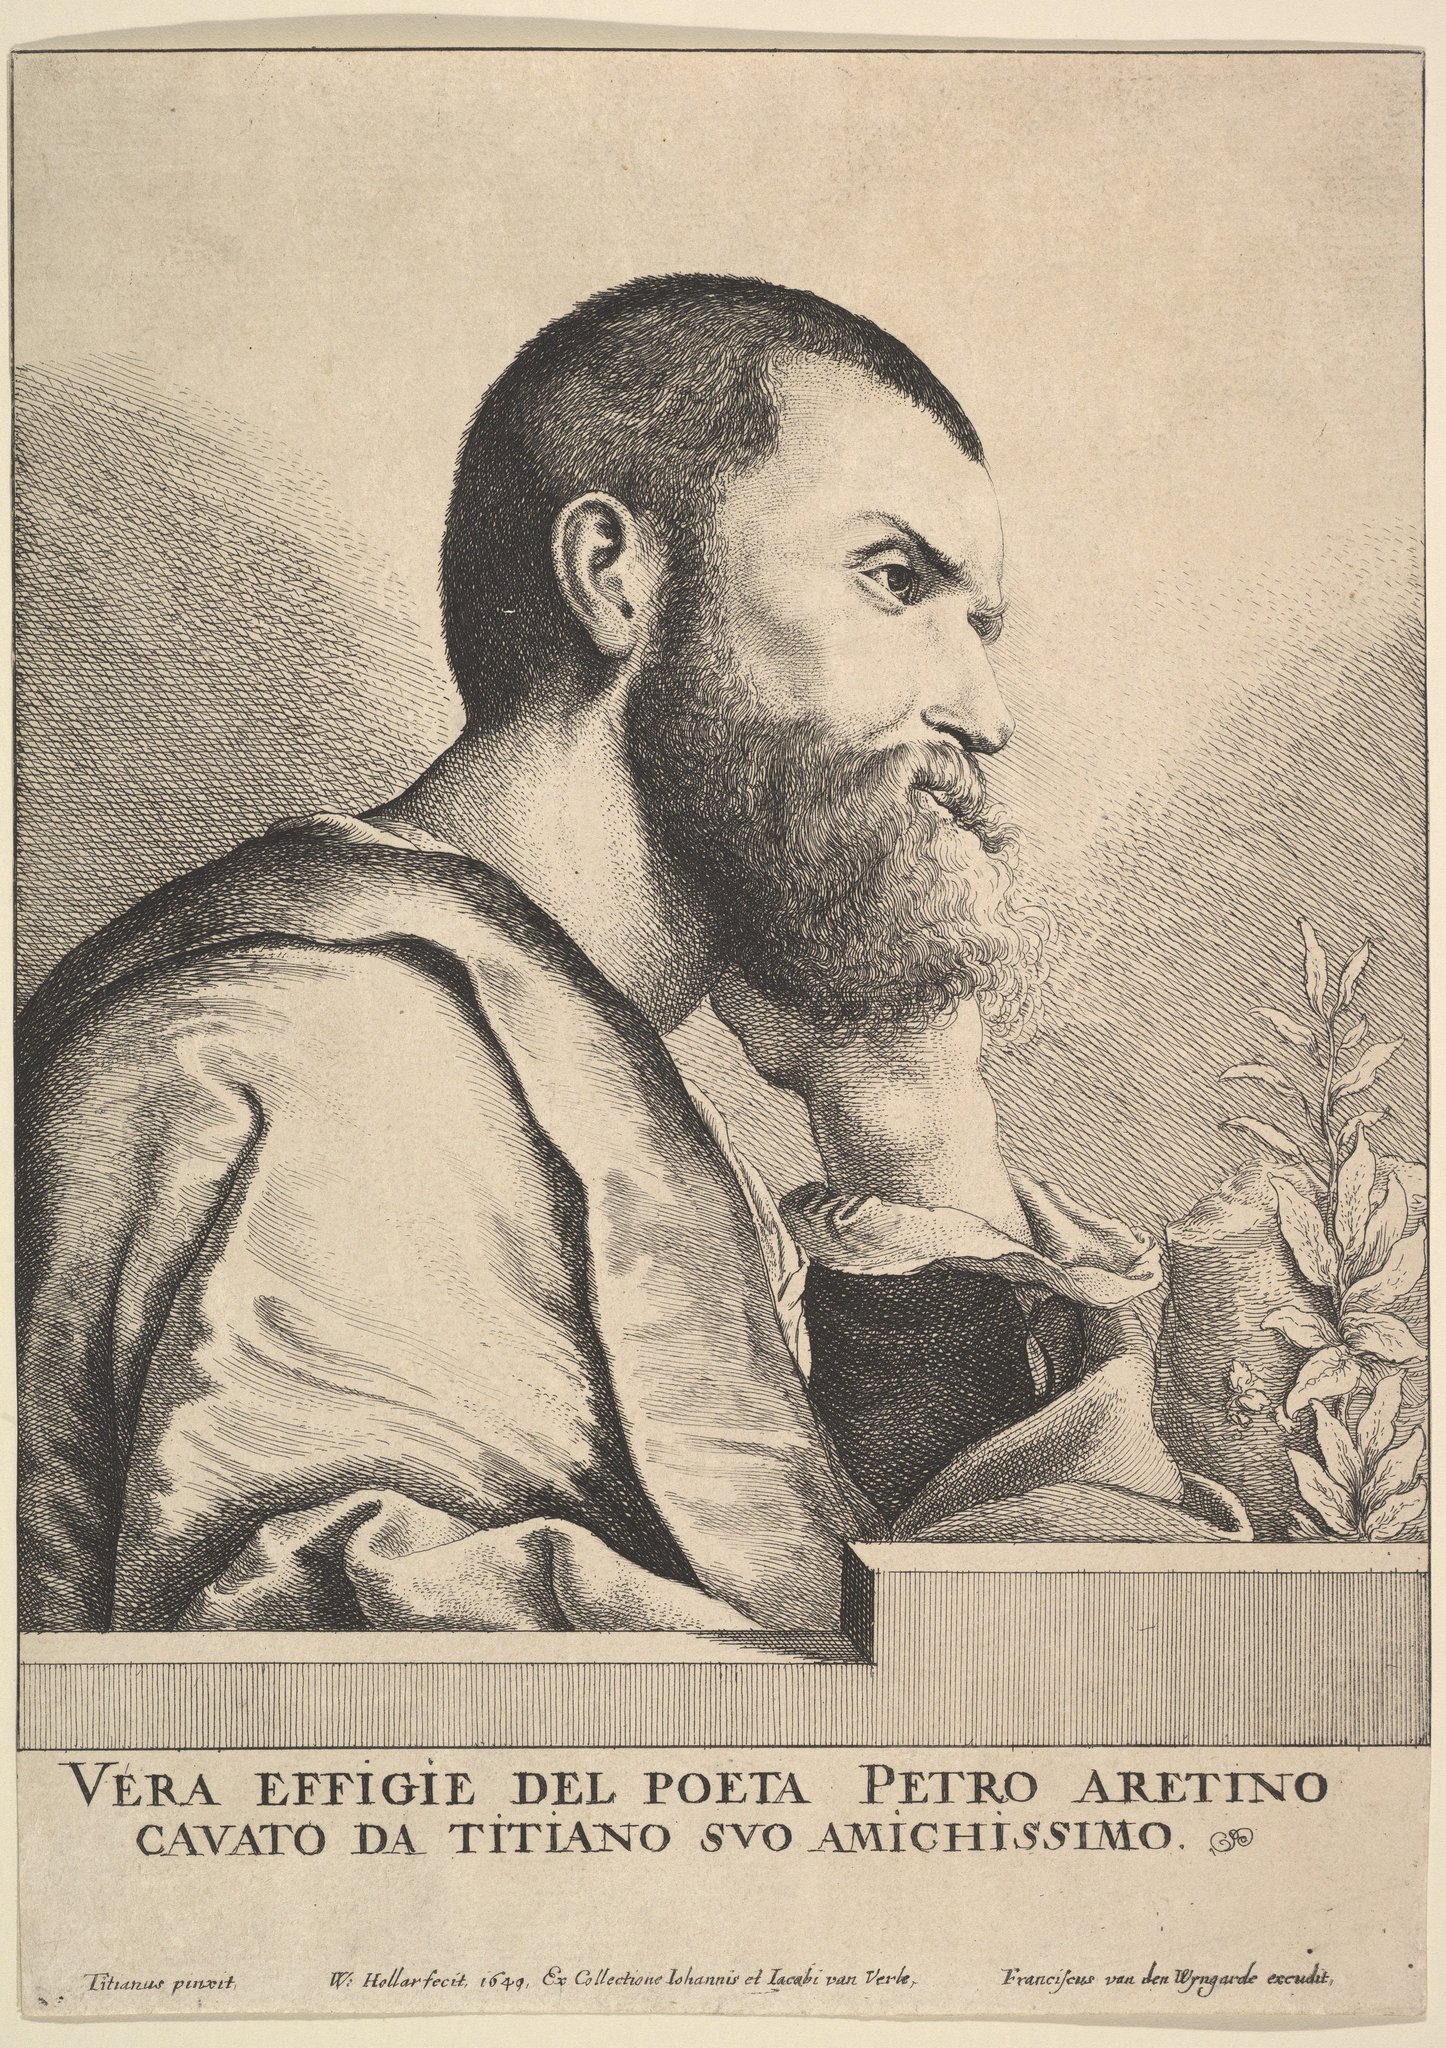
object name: print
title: Pietro Aretino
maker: wenceslaus hollar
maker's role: artist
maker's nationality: bohemian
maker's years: 1607-1677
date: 1649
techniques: etching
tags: contemplation,men,portraits,profiles